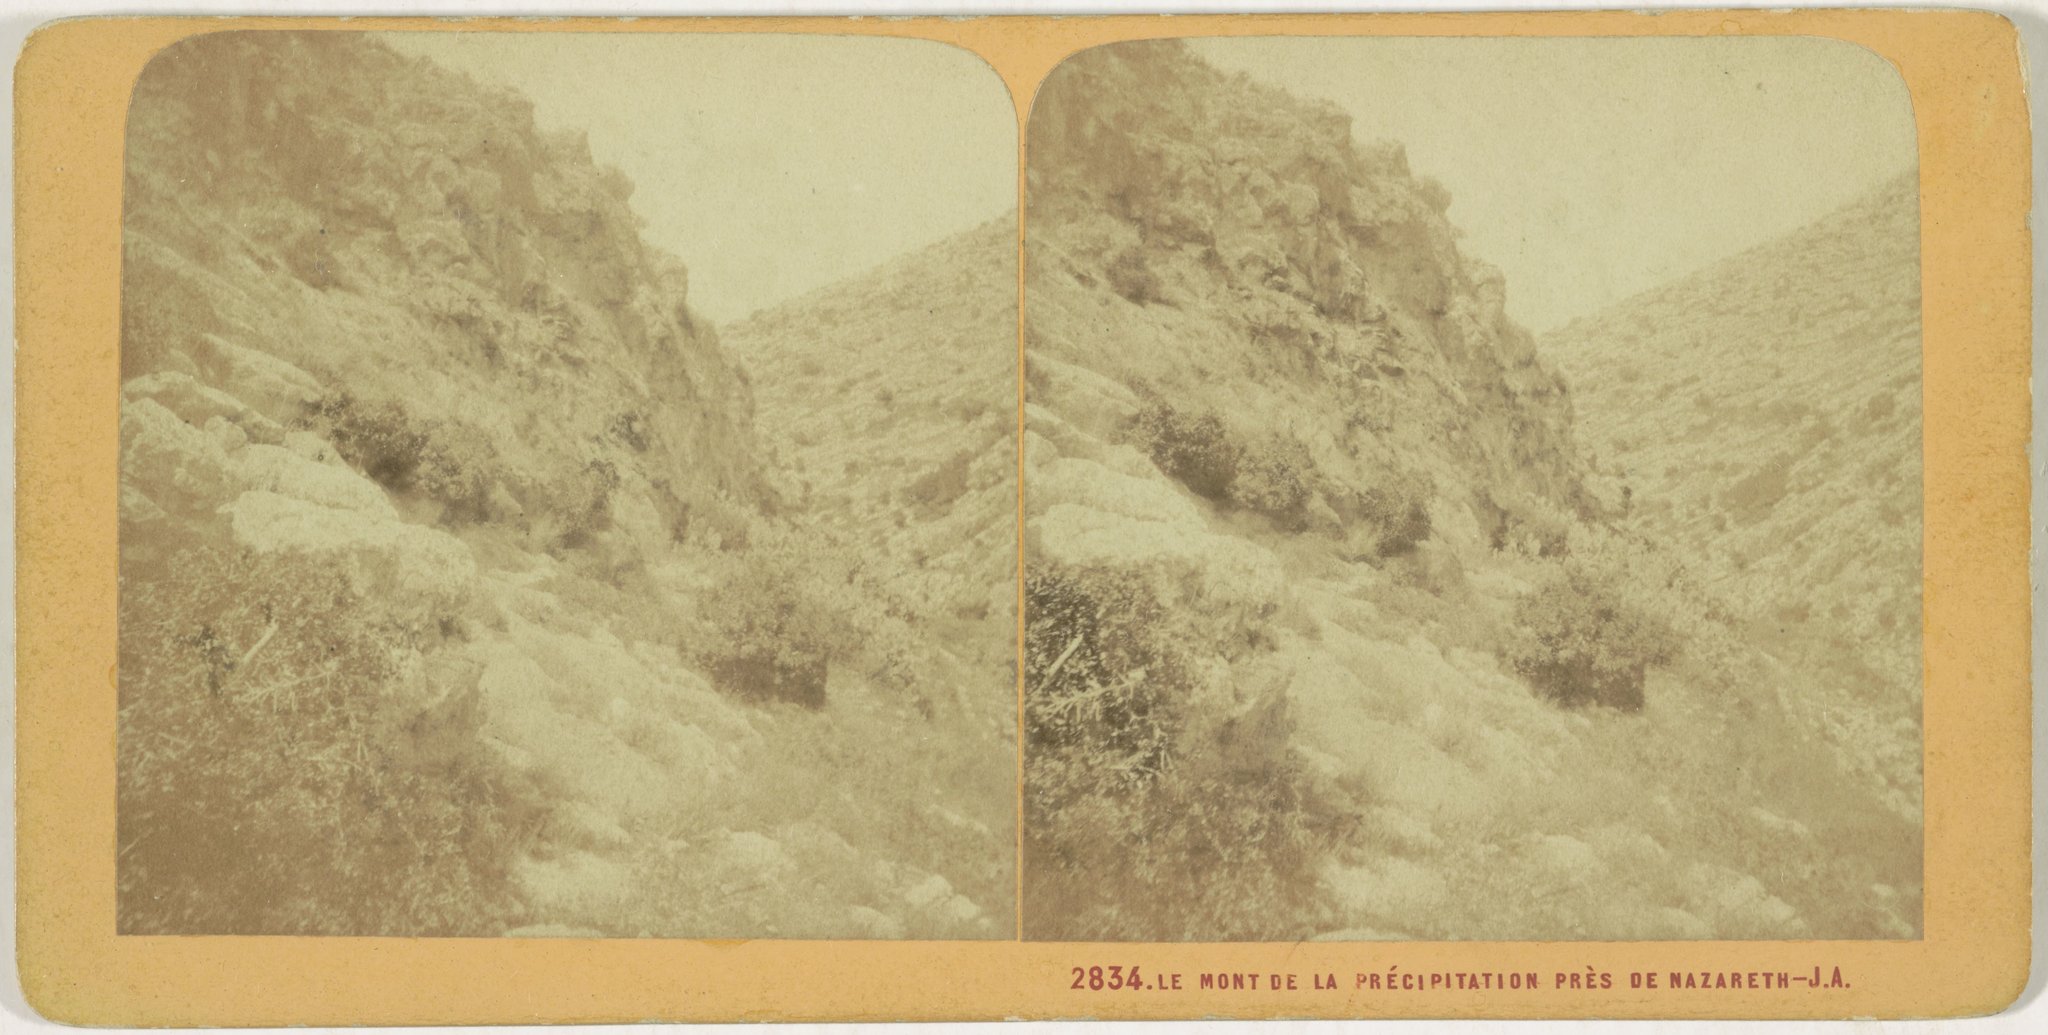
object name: stereograph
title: Berg van de Afstorting nabij Nazareth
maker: jean andrieu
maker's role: fotograaf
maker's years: 1816-1872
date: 1862-1876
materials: cardboard, paper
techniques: albumen print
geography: mount precipice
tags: mountains, mount precipice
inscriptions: number: ‘2834.’